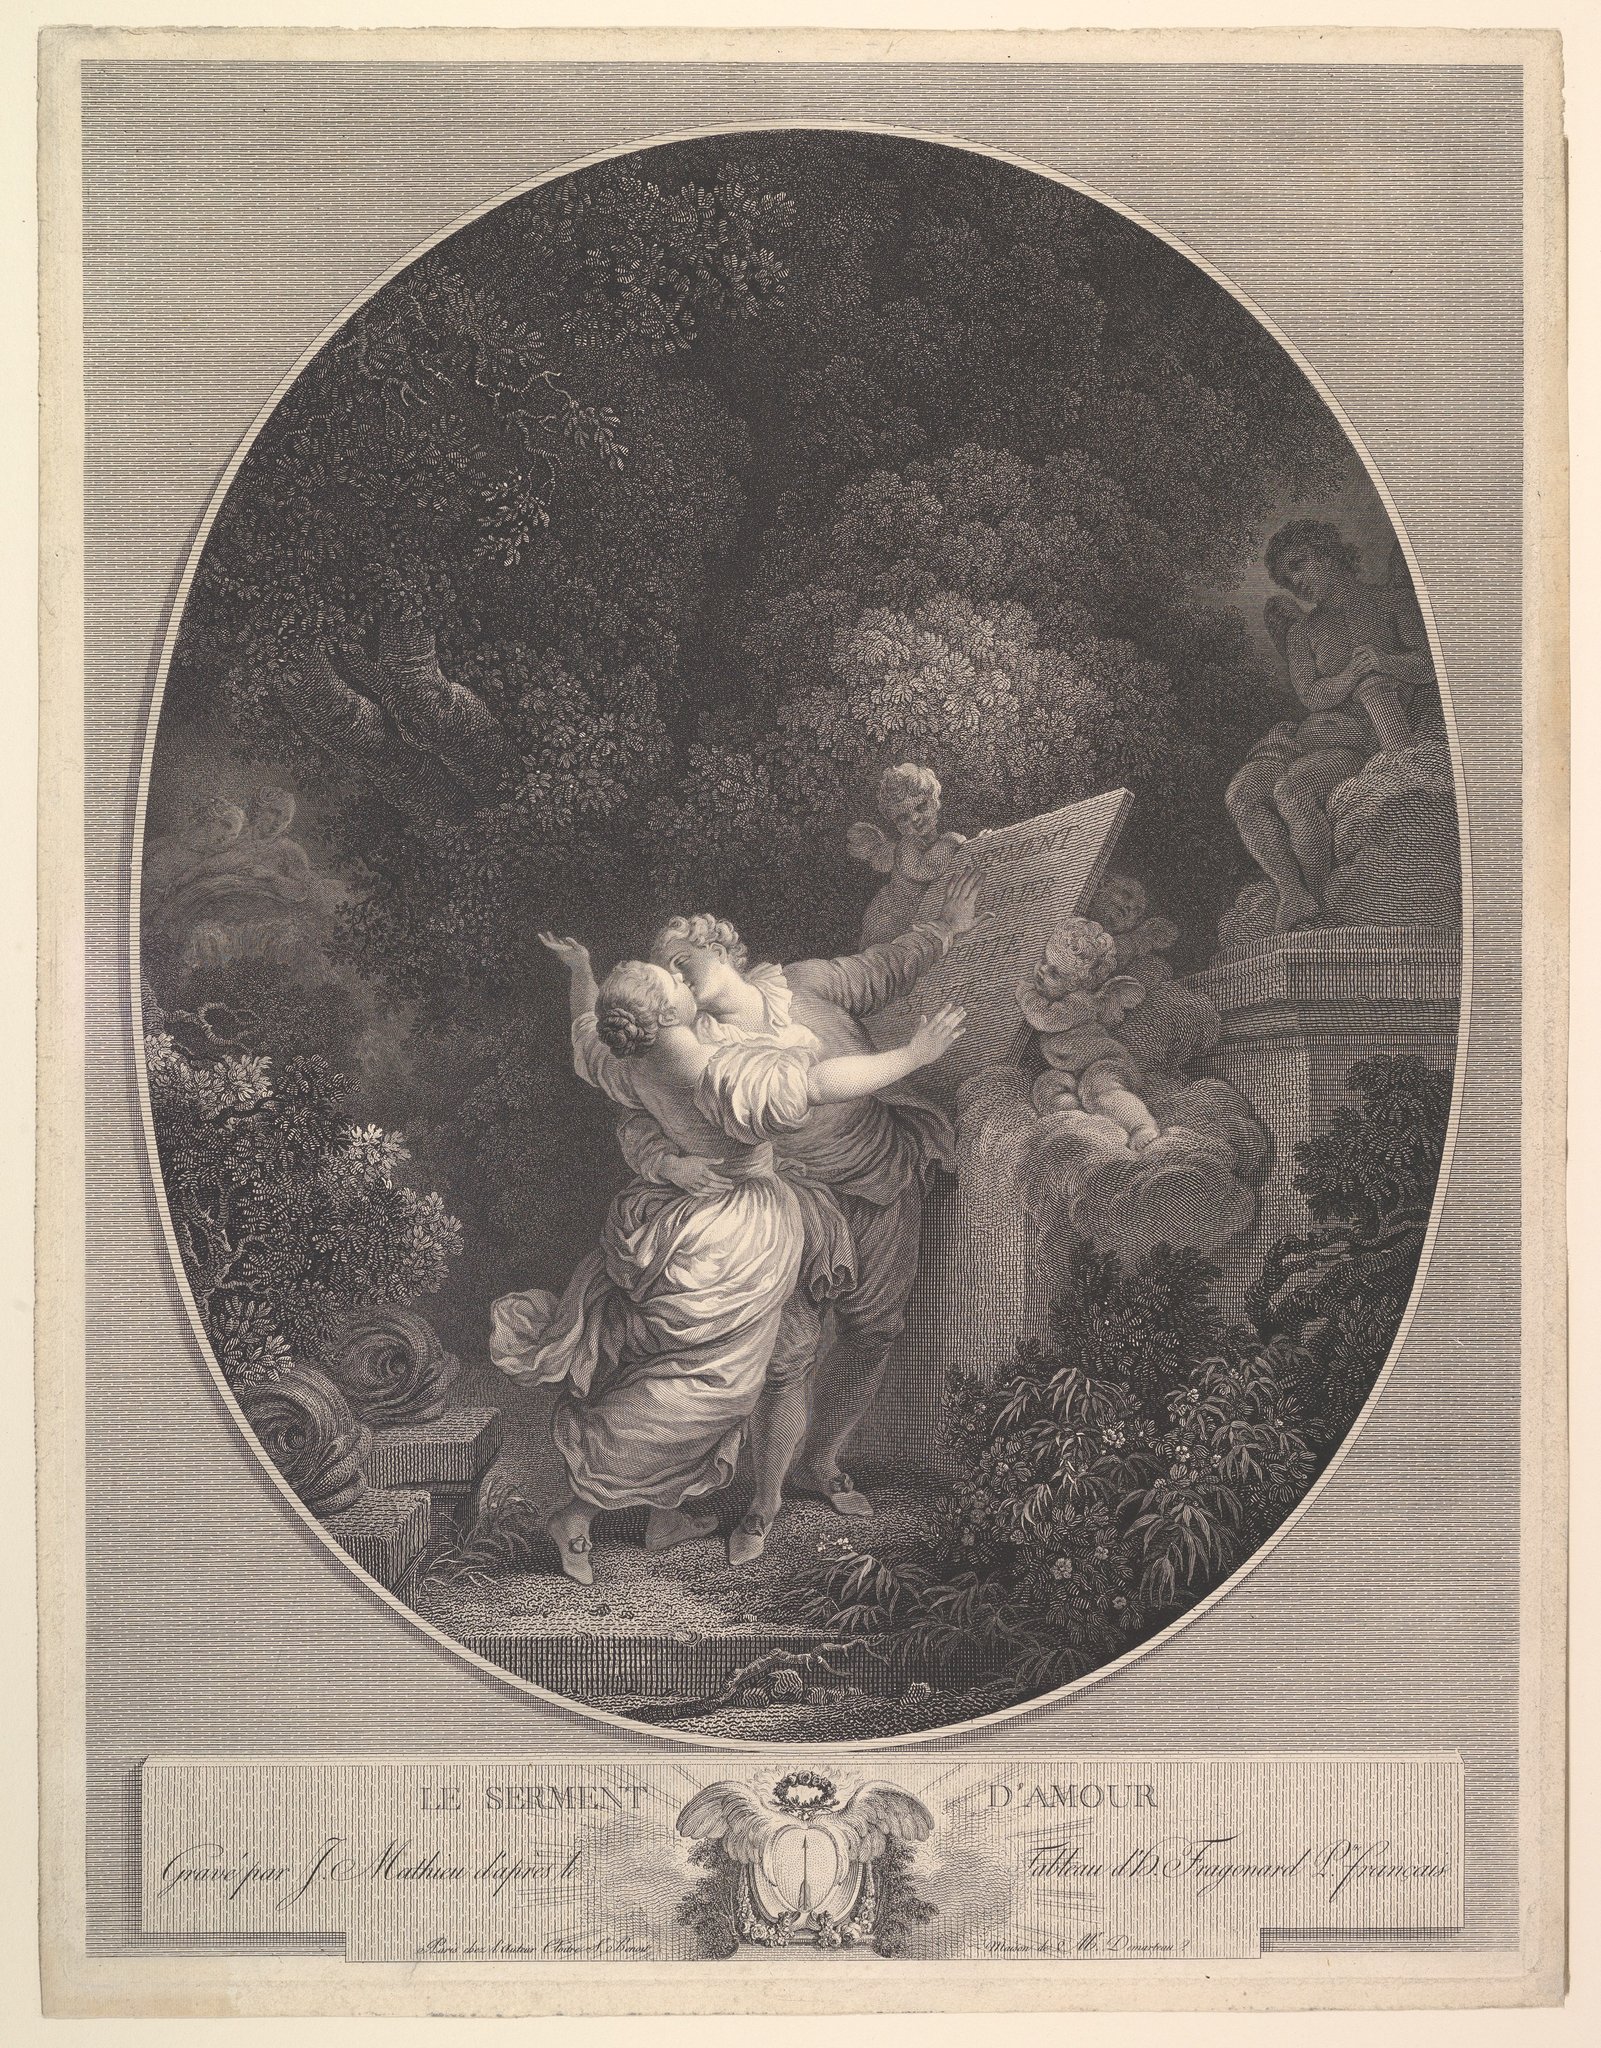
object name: print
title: Le Serment d'Amour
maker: jean honoré fragonard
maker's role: artist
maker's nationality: french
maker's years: 1732-1806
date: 1786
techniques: etching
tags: love,couples,men,women,putti